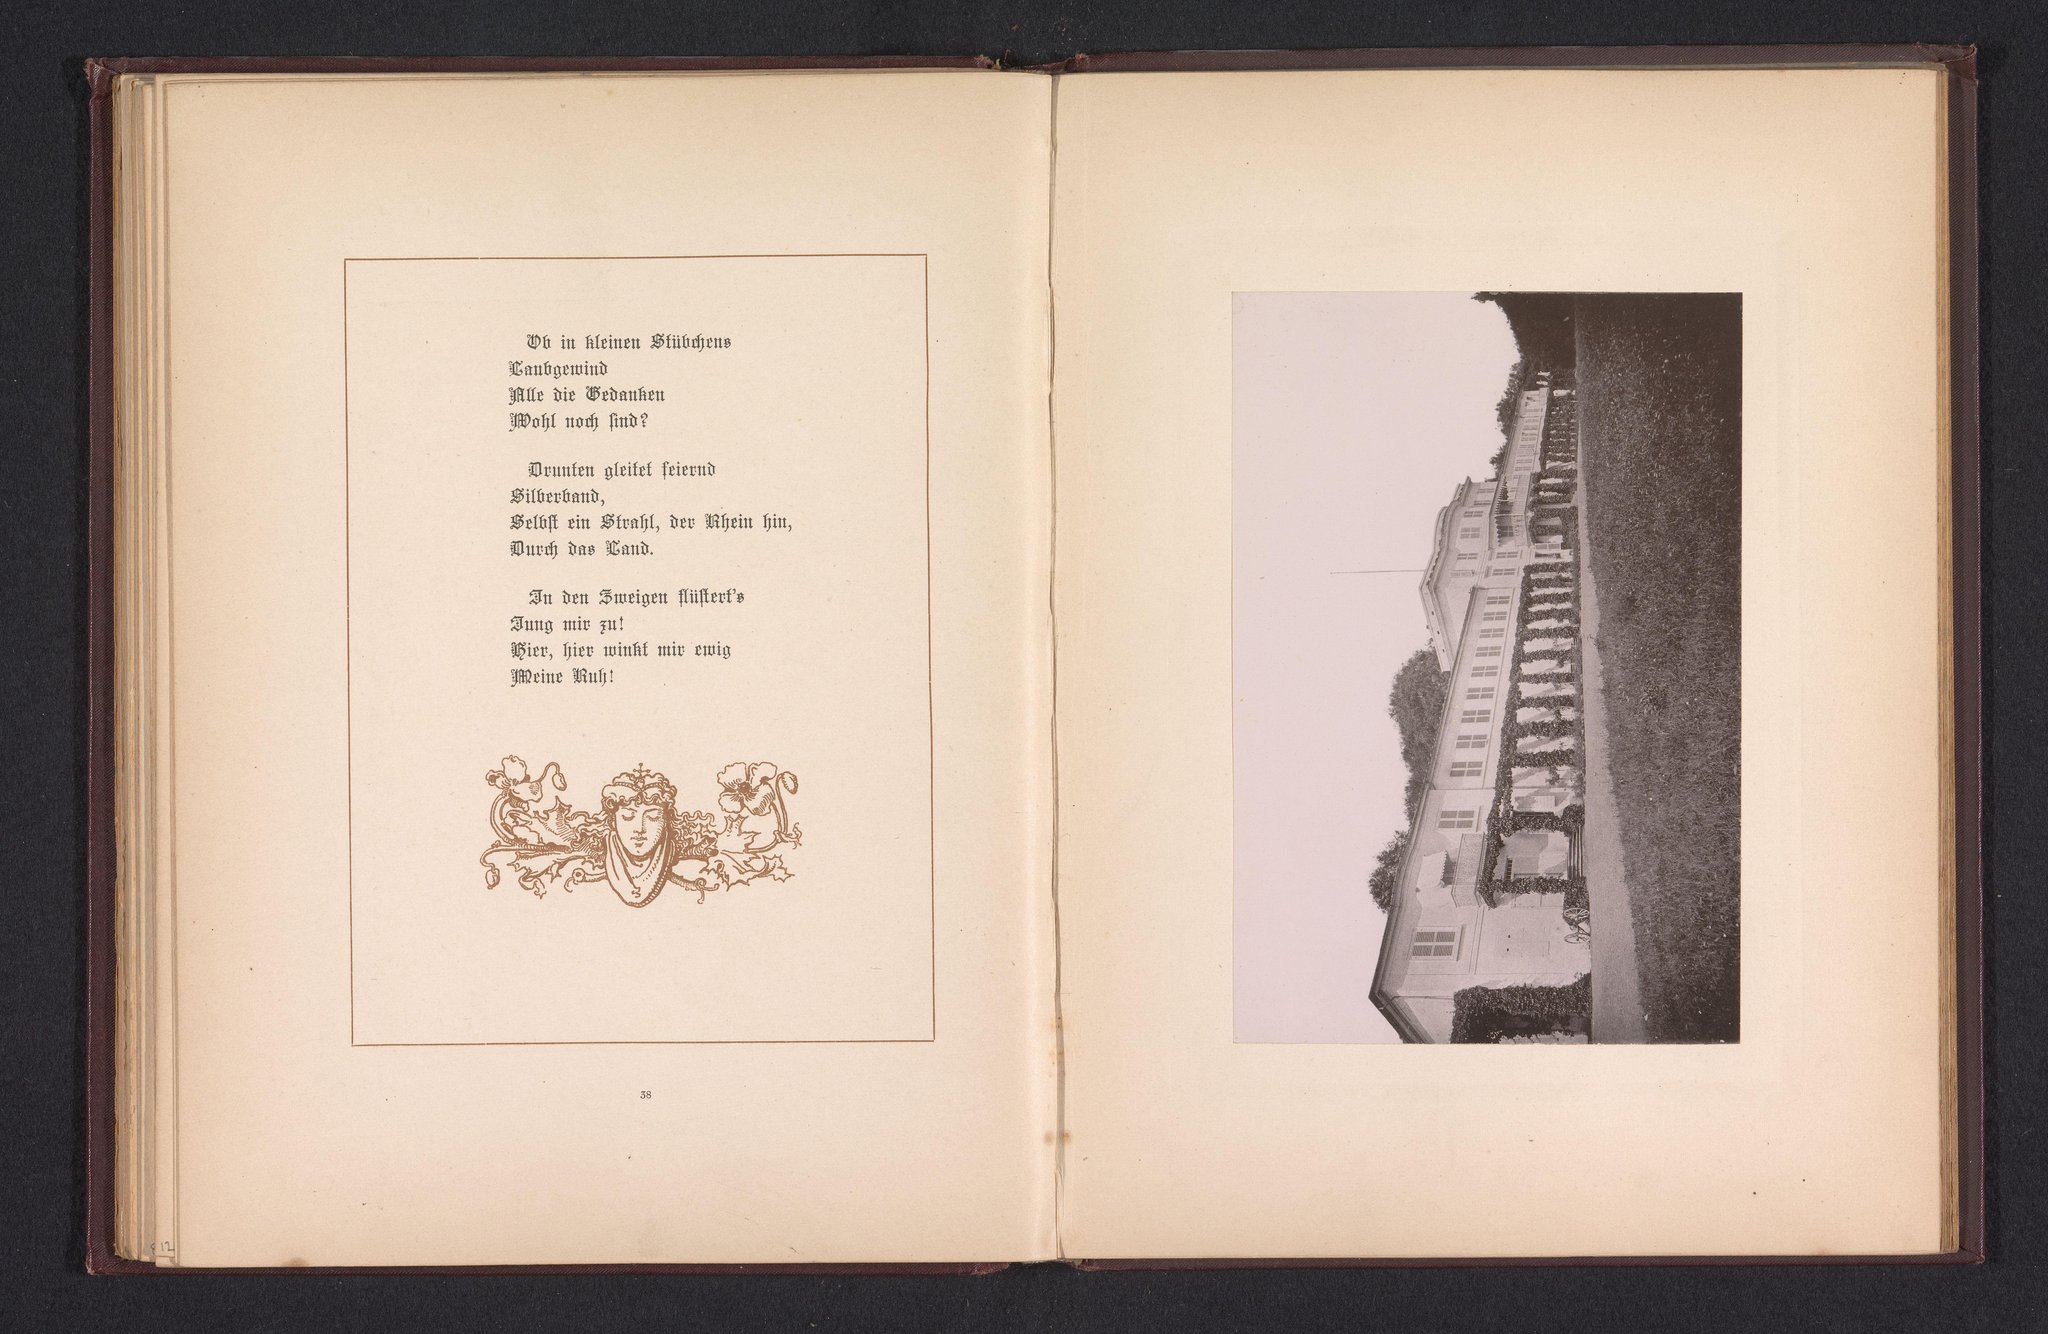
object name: page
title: Gezicht op vermoedelijk Seeschloss Monrepos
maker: Anonymous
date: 1881-1891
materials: paper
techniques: photograph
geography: dresden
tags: palace, façade (of house or building)